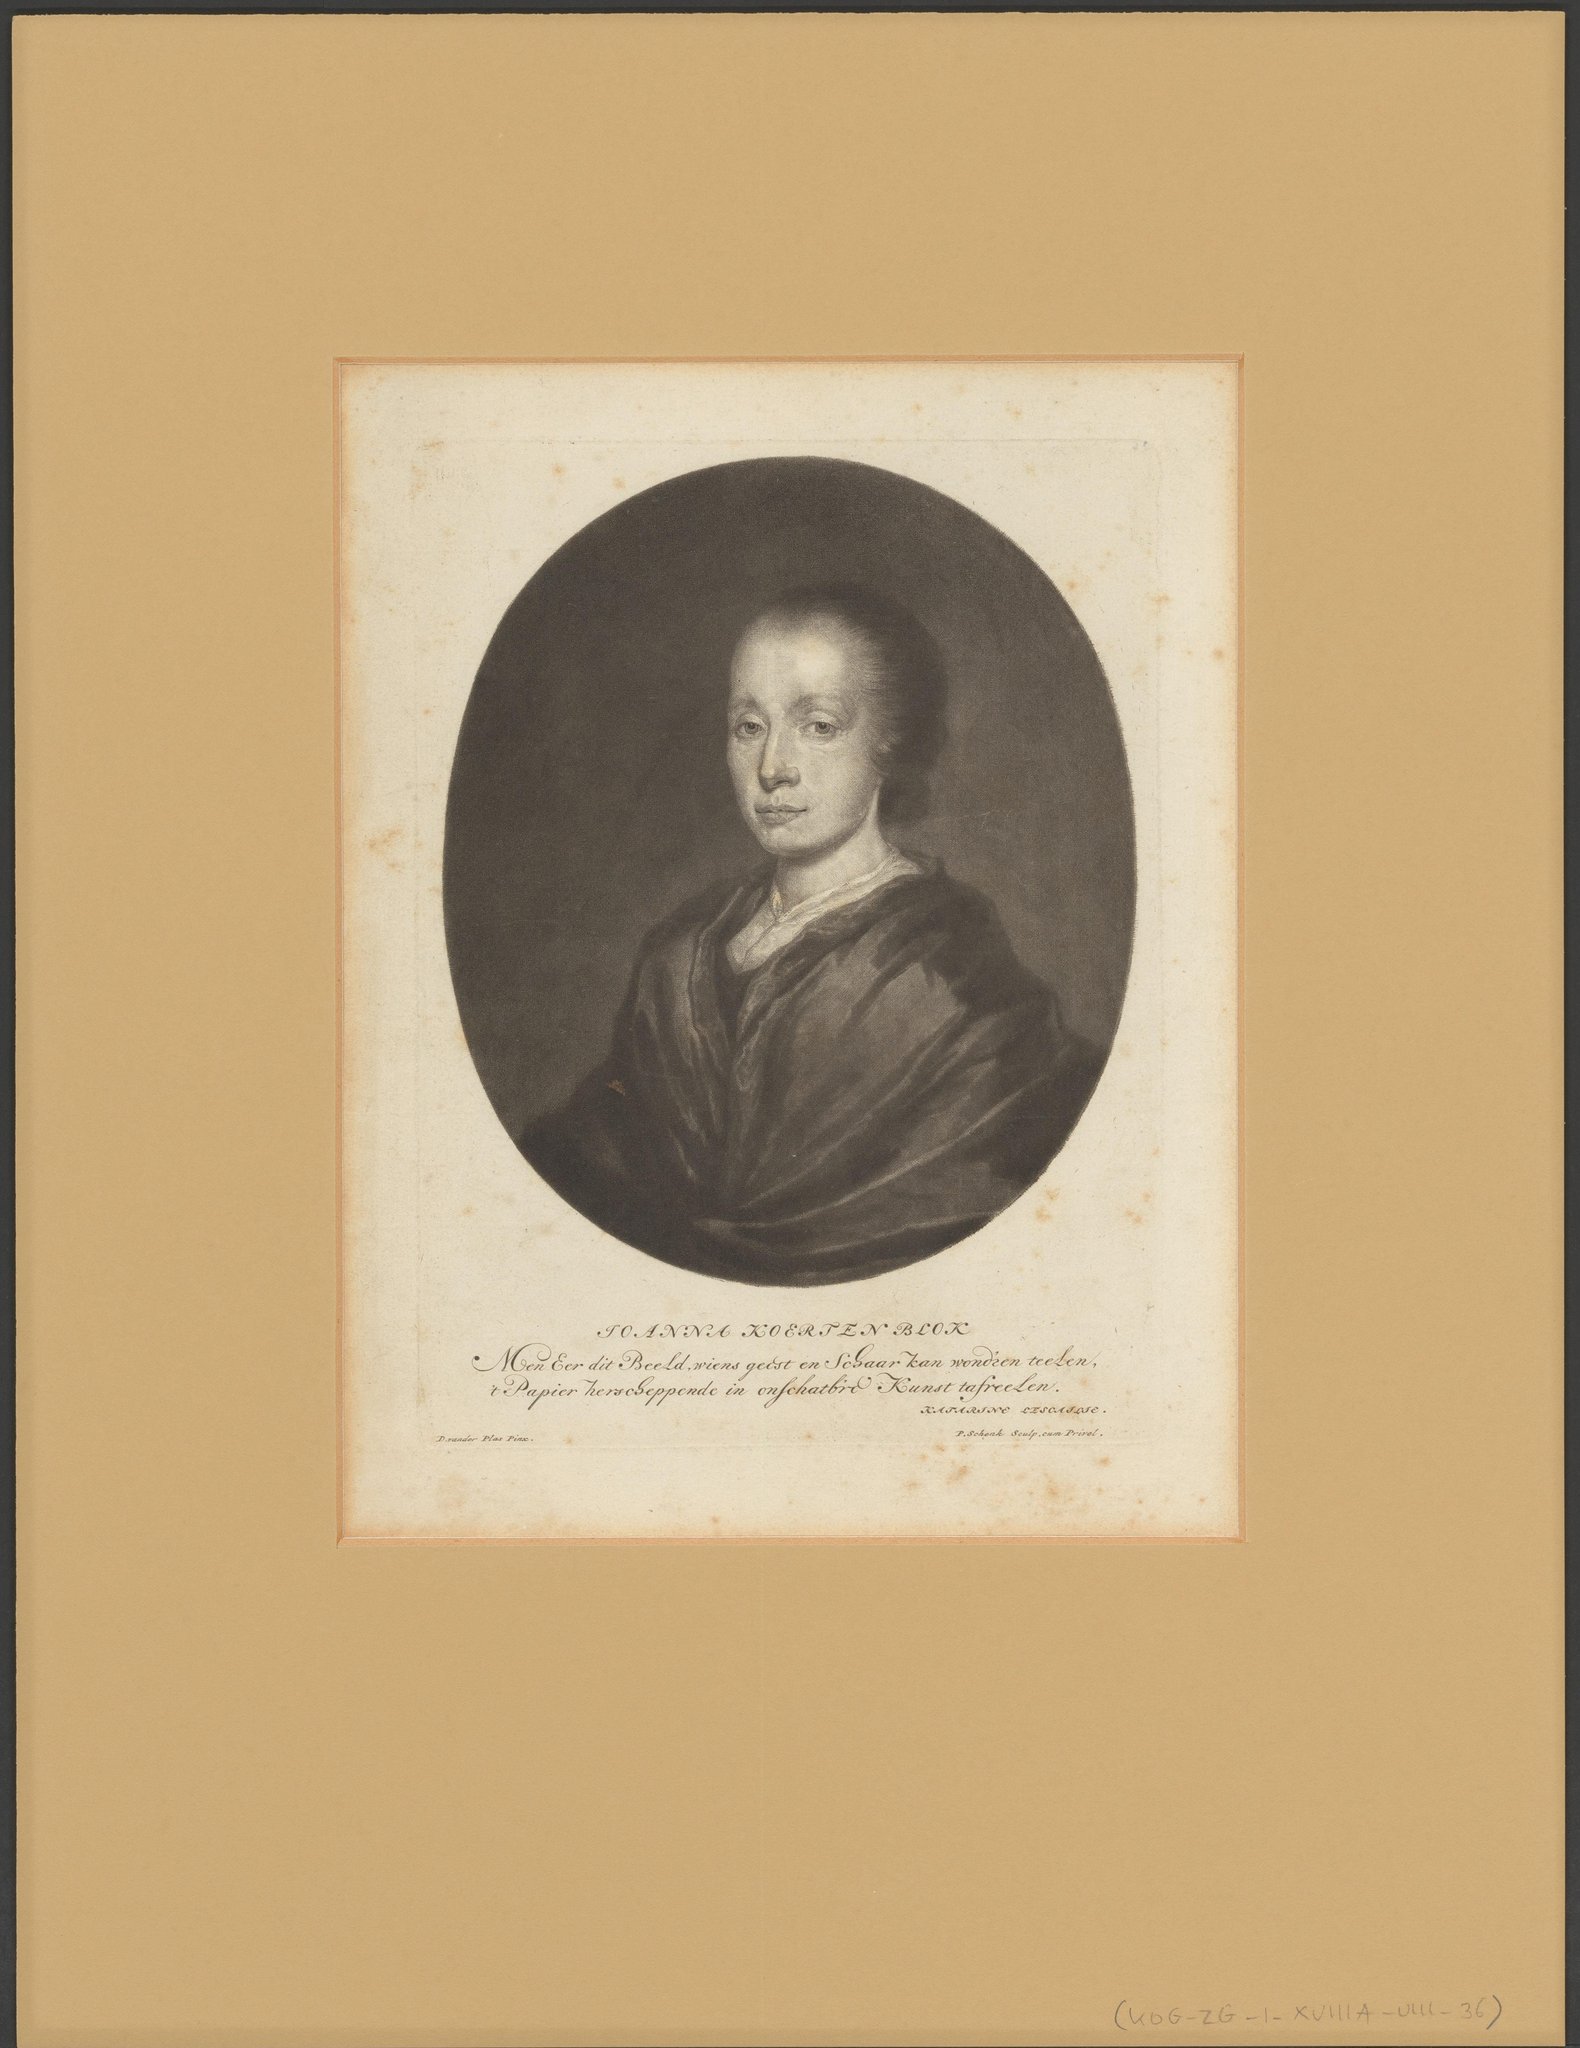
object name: print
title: Portret van Johanna Koerten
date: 1701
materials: paper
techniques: engraving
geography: amsterdam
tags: draughtsman, johanna koerten, historical persons - bb - woman, portrait, self-portrait of artist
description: Portret van de knipkunstenares Johanna Koerten. Onder het portret een tweeregelig vers. Onderwerpsrubrieken binnen de Atlas Zeden en Gewoonten: Schoone kunsten, Knipkunst.